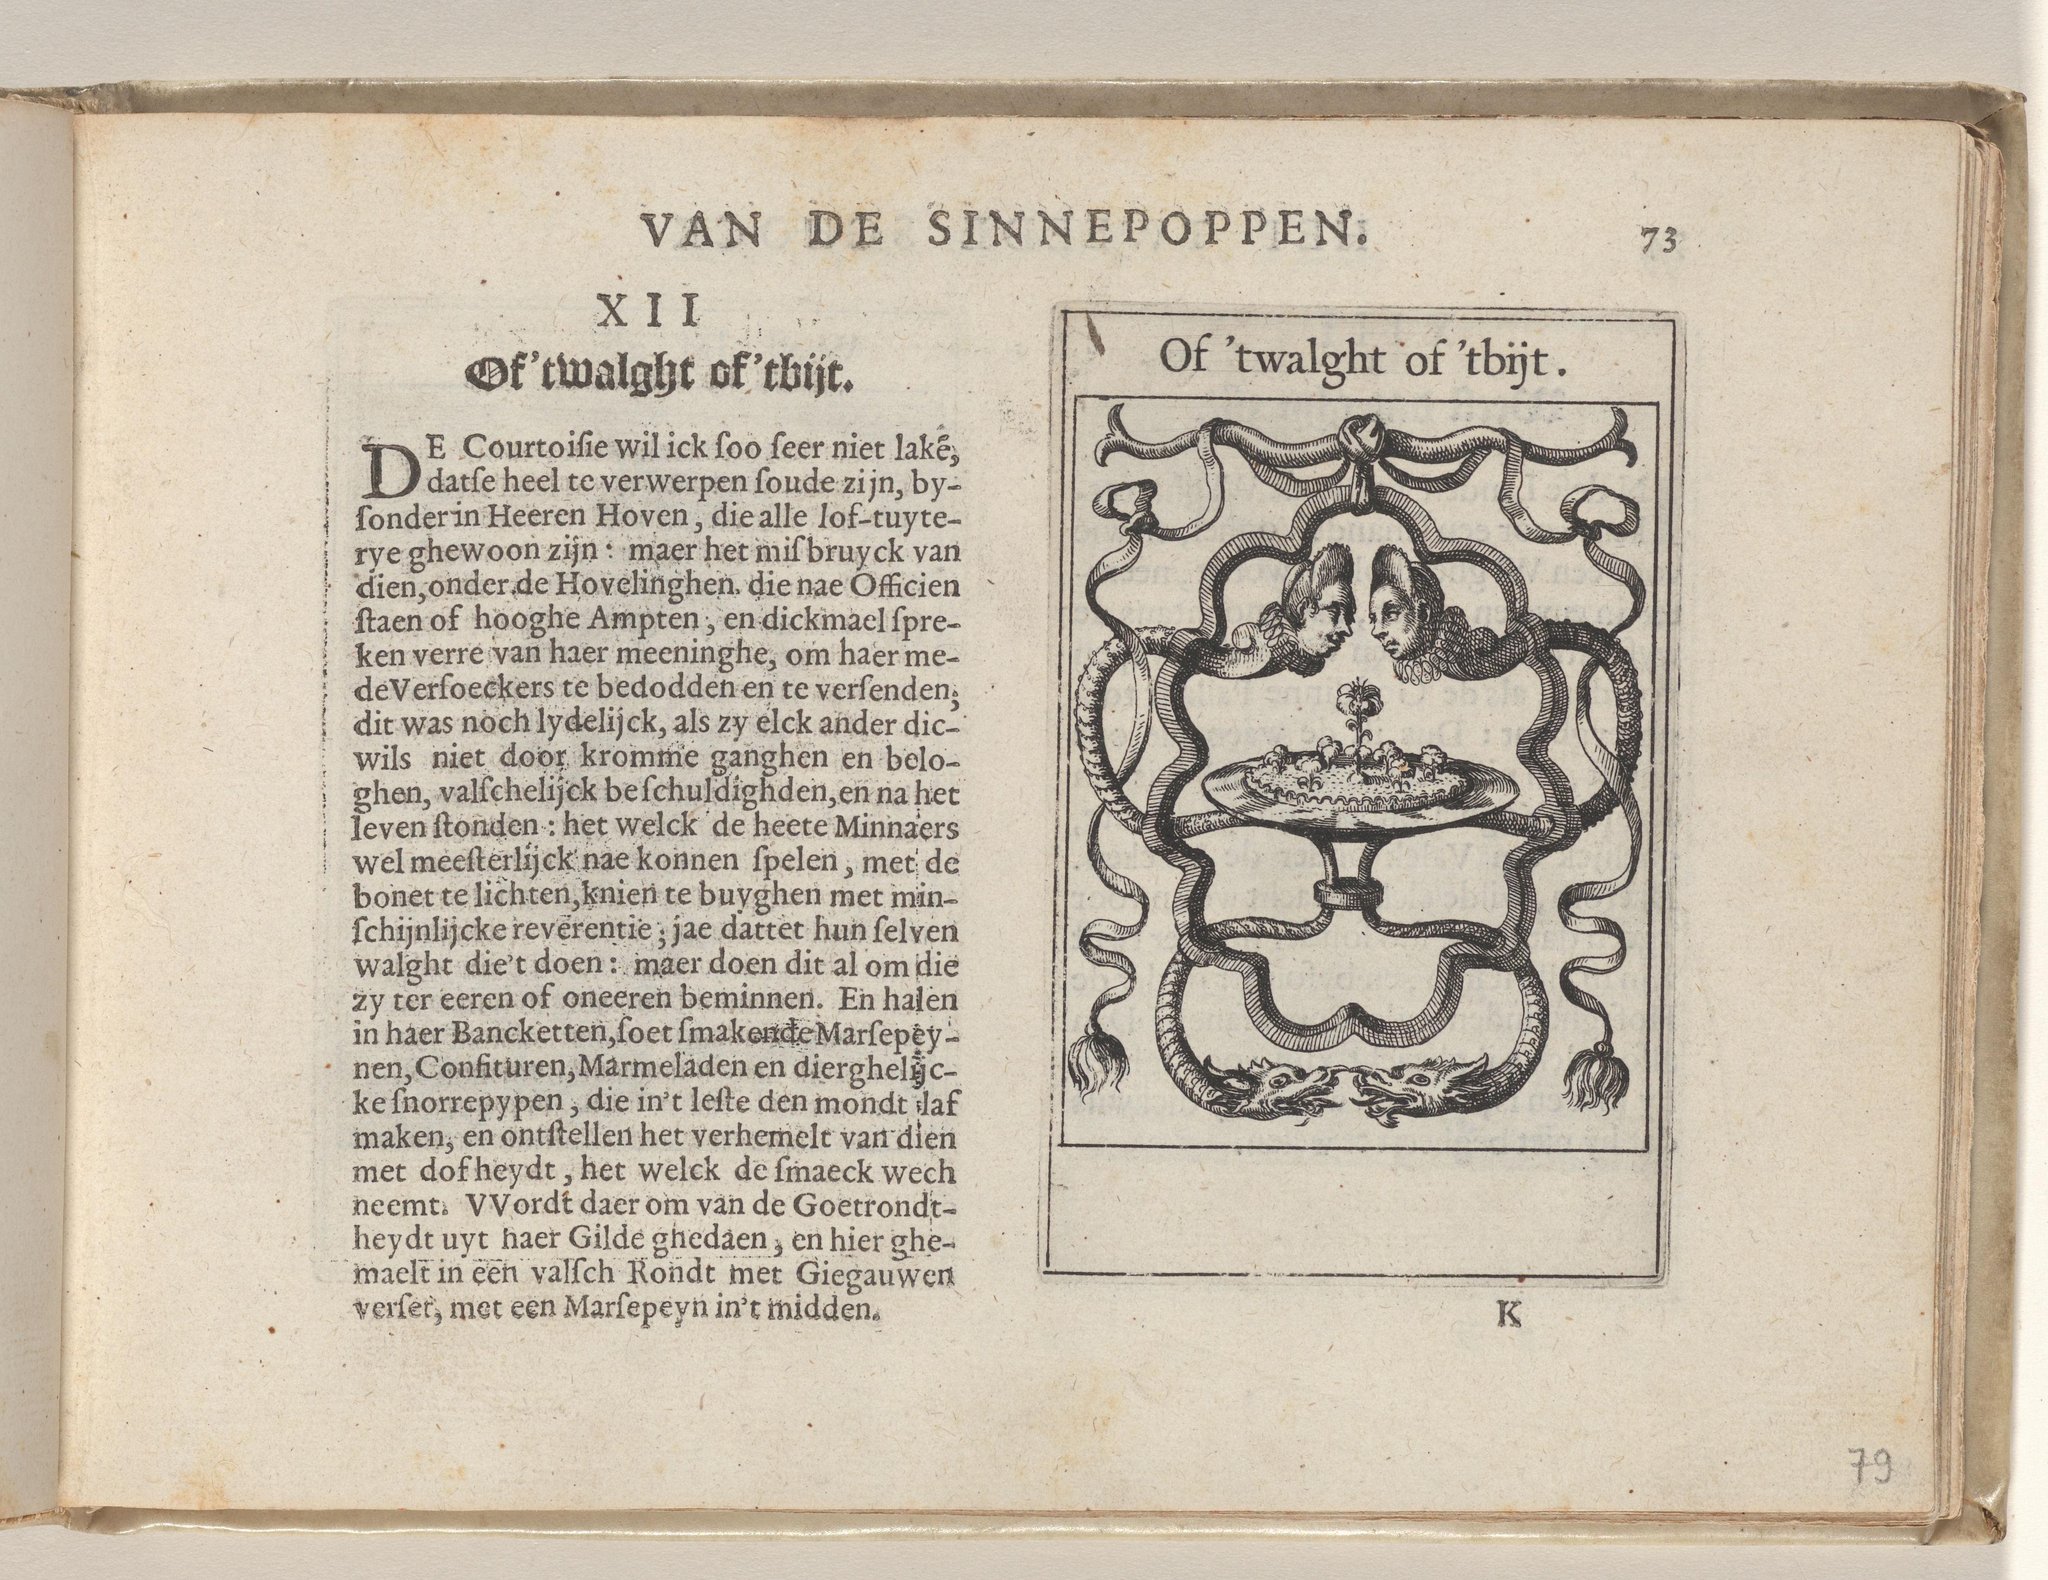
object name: album leaf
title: XII Of 't walght of 't bijt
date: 1614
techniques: engraving, printing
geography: amsterdam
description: XII Of 't walght of 't bijt. Tweede schok. Onderdeel van 'Sinnepoppen', R. Visscher, 1614.